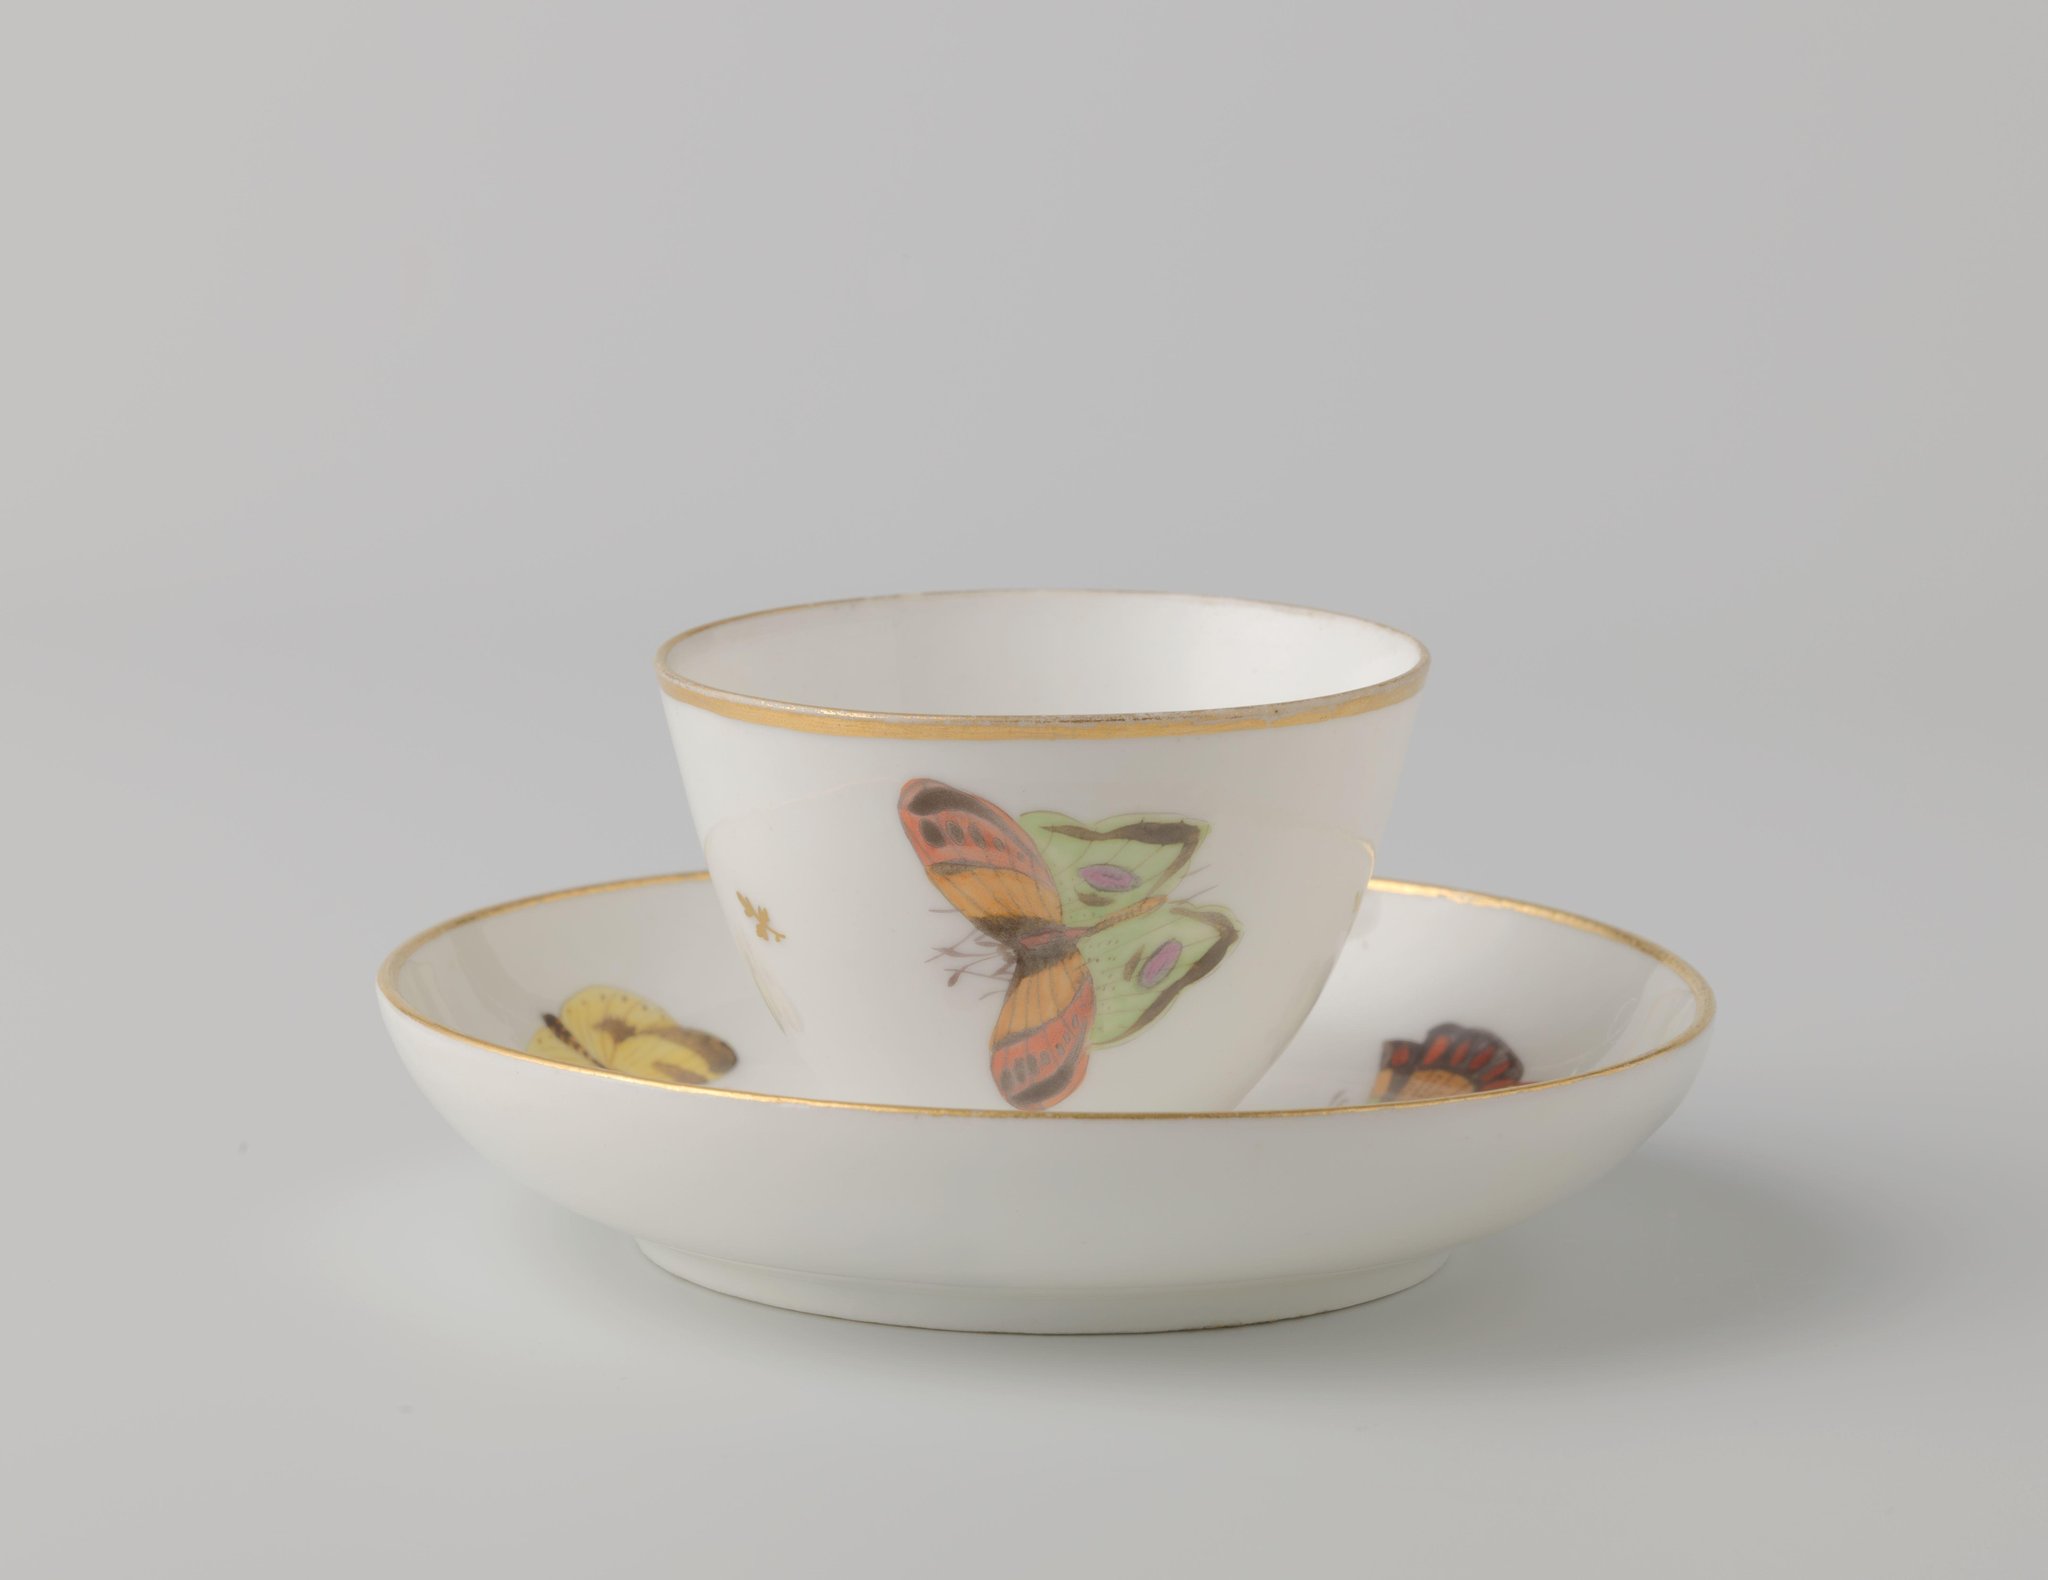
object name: kop en schotel, kop en schotel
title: Kop beschilderd met vlinders en libellen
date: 1784-1809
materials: porcelain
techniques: painted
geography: ouder-amstel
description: Kop zonder oor veelkleurig beschilderd met vlinders en libellen. Gemerkt: Amstel.